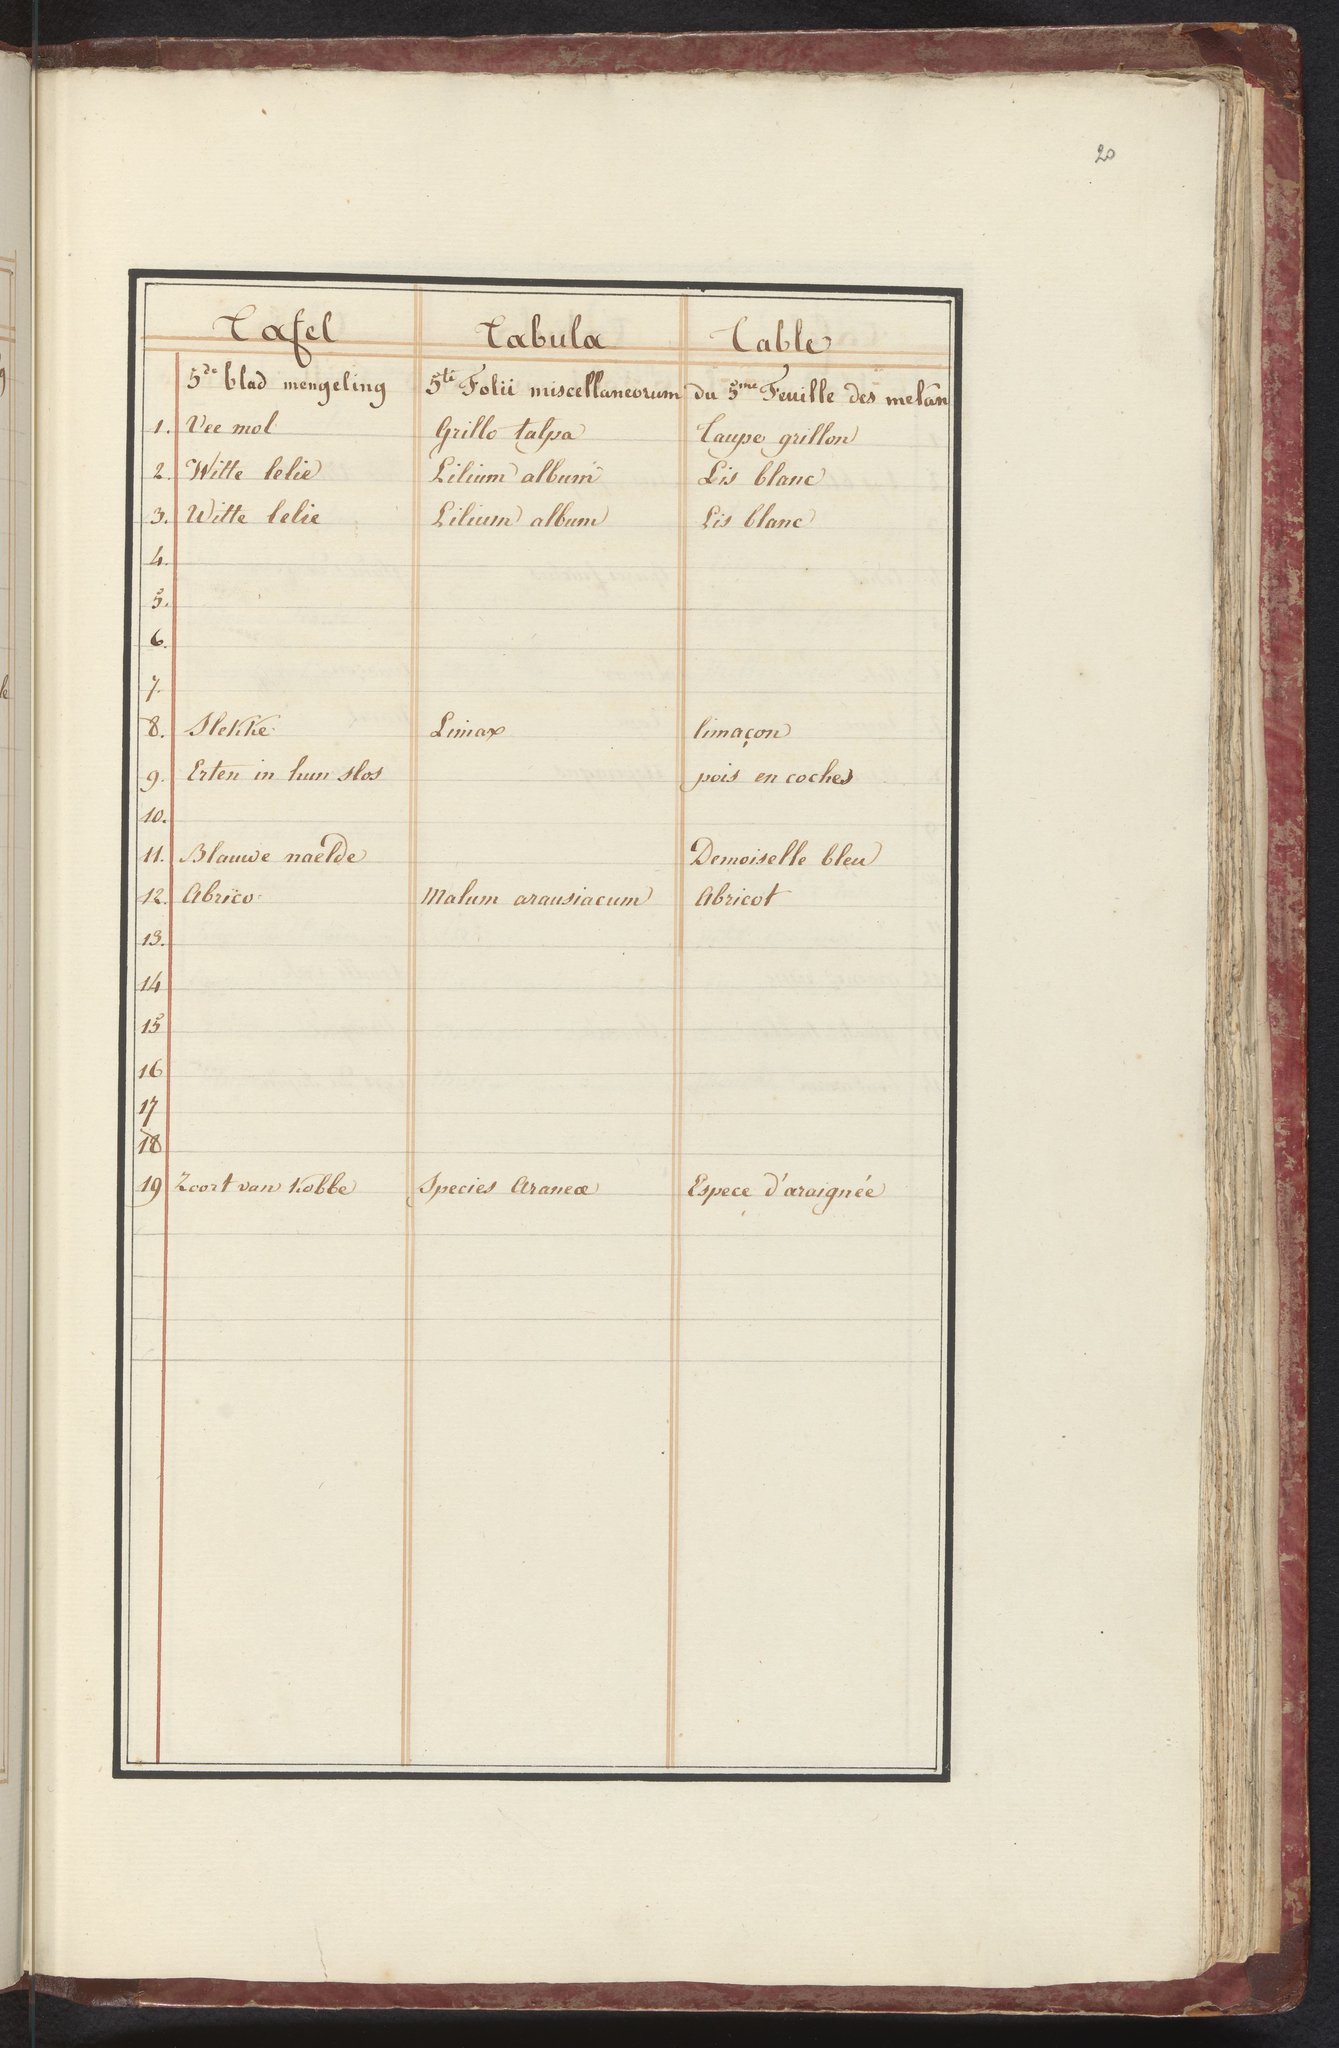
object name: manuscript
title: Lijst van dieren en planten in het vijfde ensemble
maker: joseph van huerne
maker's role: kunstliefhebber, mecenas, verzamelaar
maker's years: 1752-1844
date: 1809-1814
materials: ink, paper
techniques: handwriting, pen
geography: bruges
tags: handwriting, written text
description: Schema met een lijst in drie kolommen van de dieren en planten afgebeeld in het vijfde ensemble, nummers 1-19. Onderdeel van het zevende album met tekeningen van reptielen, amfibieën en natuurhistorische ensembles. Het zevende van twaalf albums met aquarellen van dieren, vogels en planten bekend rond 1600, gemaakt in opdracht van keizer Rudolf II. Met toelichting in Nederlands, Latijn en Frans.